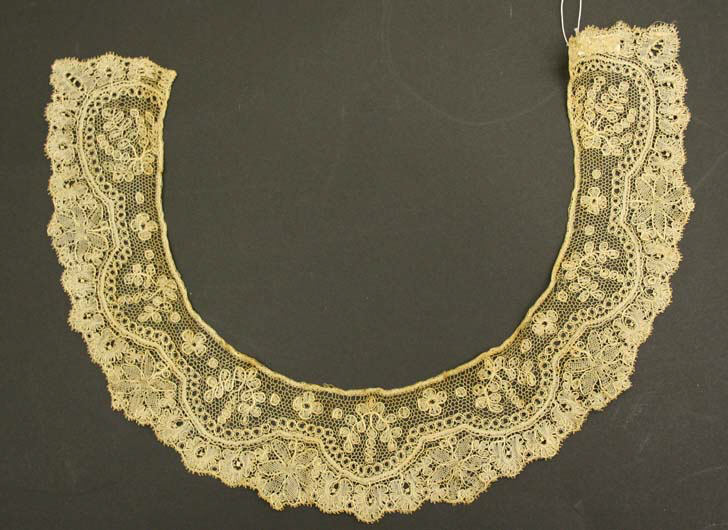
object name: collar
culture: american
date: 1700-1942